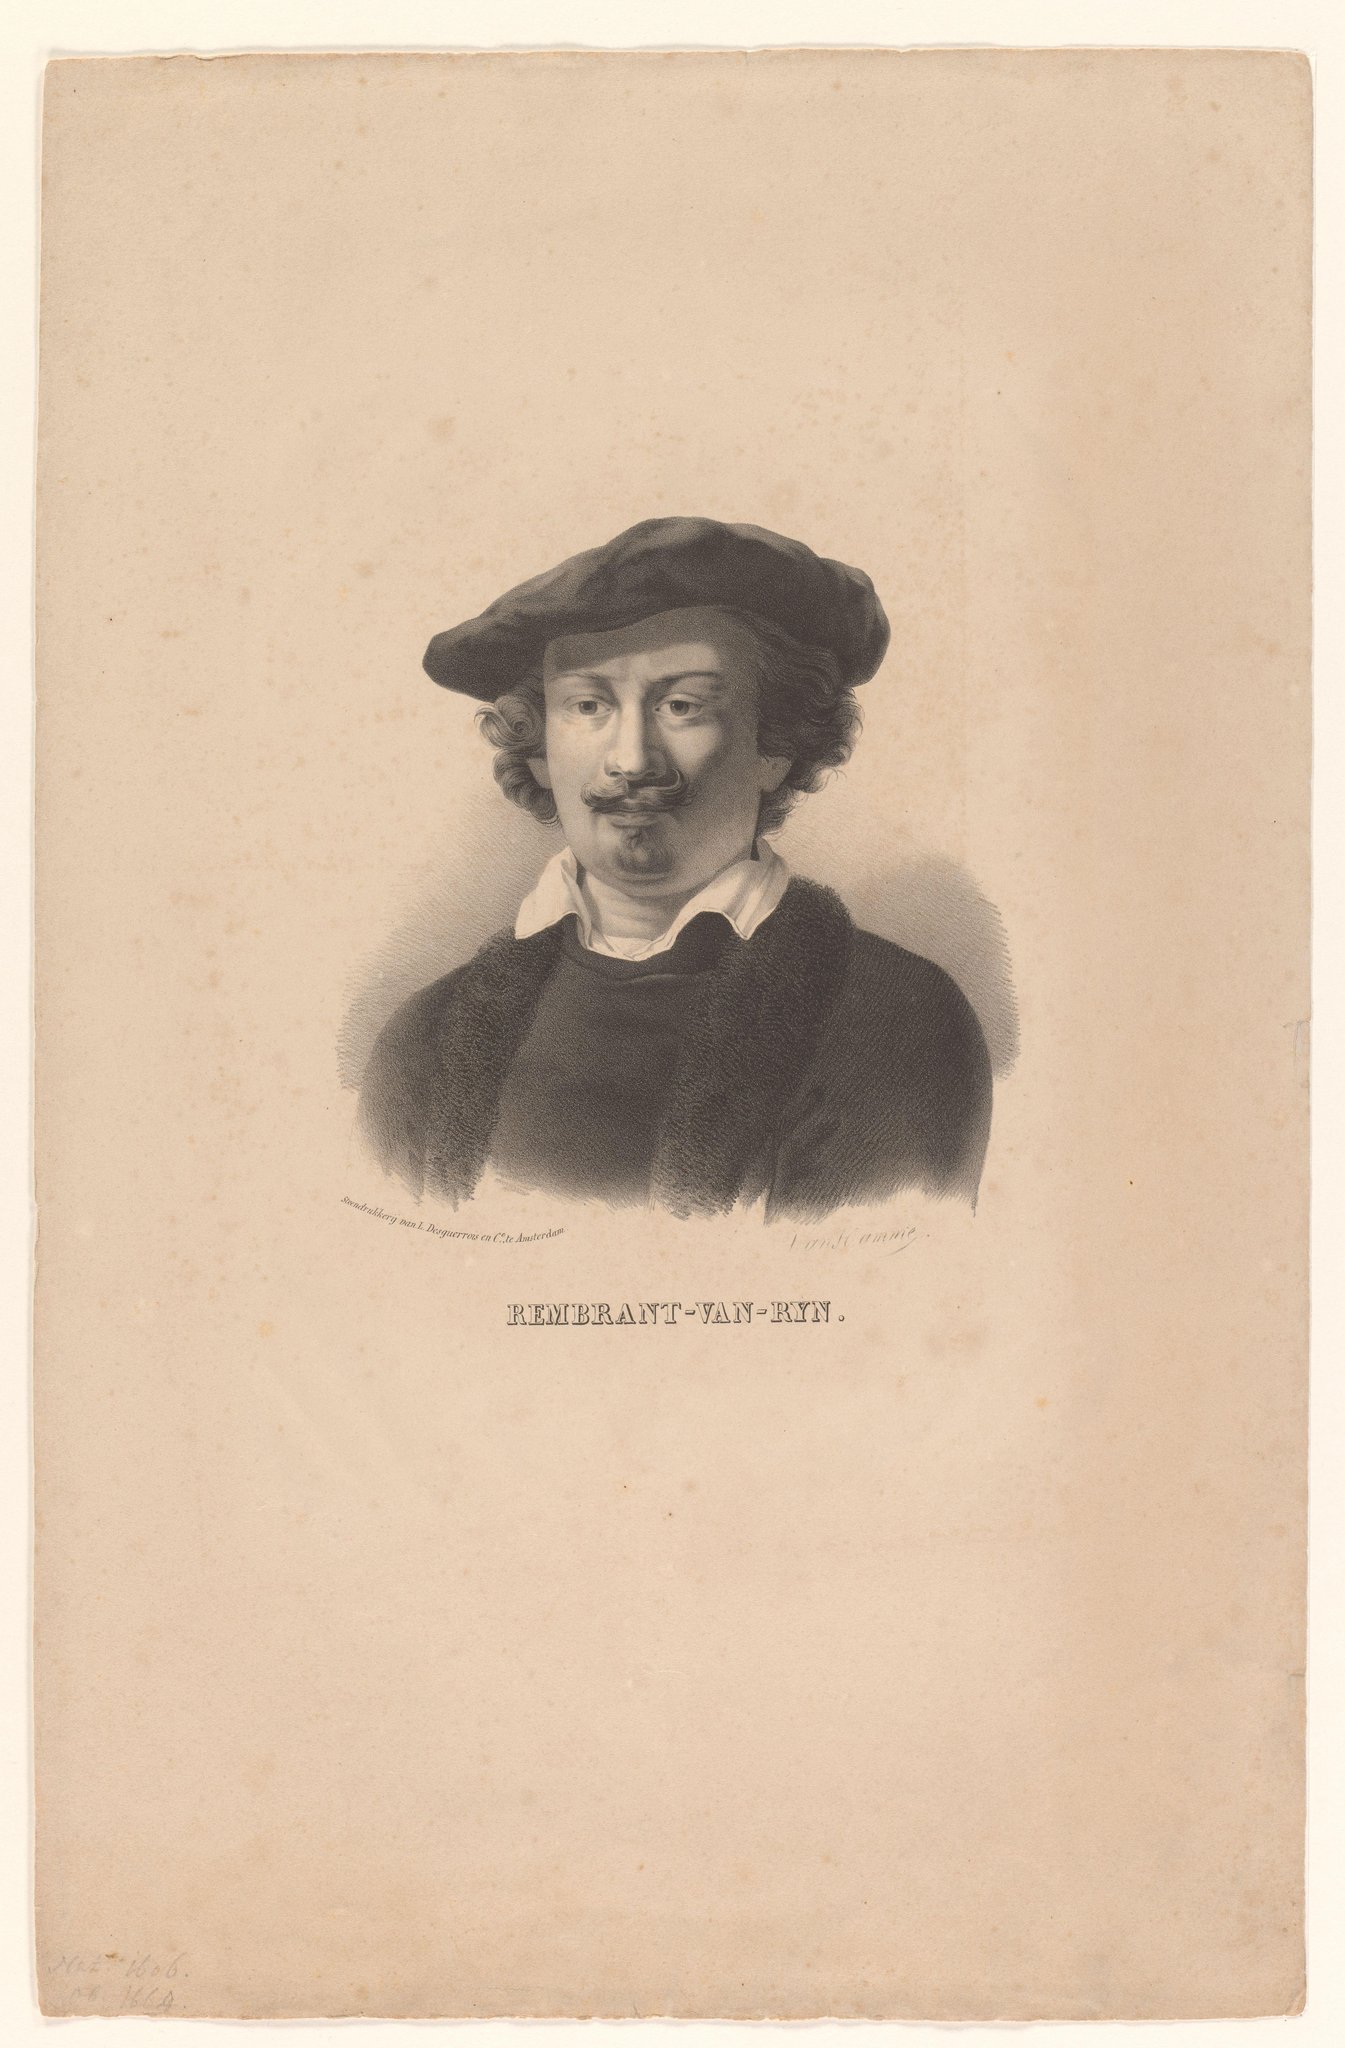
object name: print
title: Portret van Rembrandt van Rijn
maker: p.a. vanhamme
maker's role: print maker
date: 1827-1907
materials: paper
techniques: lithograph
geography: amsterdam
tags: leiden, amsterdam, painter, print maker, draughtsman, rembrandt van rijn, adult man, historical persons, portrait, self-portrait of artist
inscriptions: collector's mark: Lugt 2228